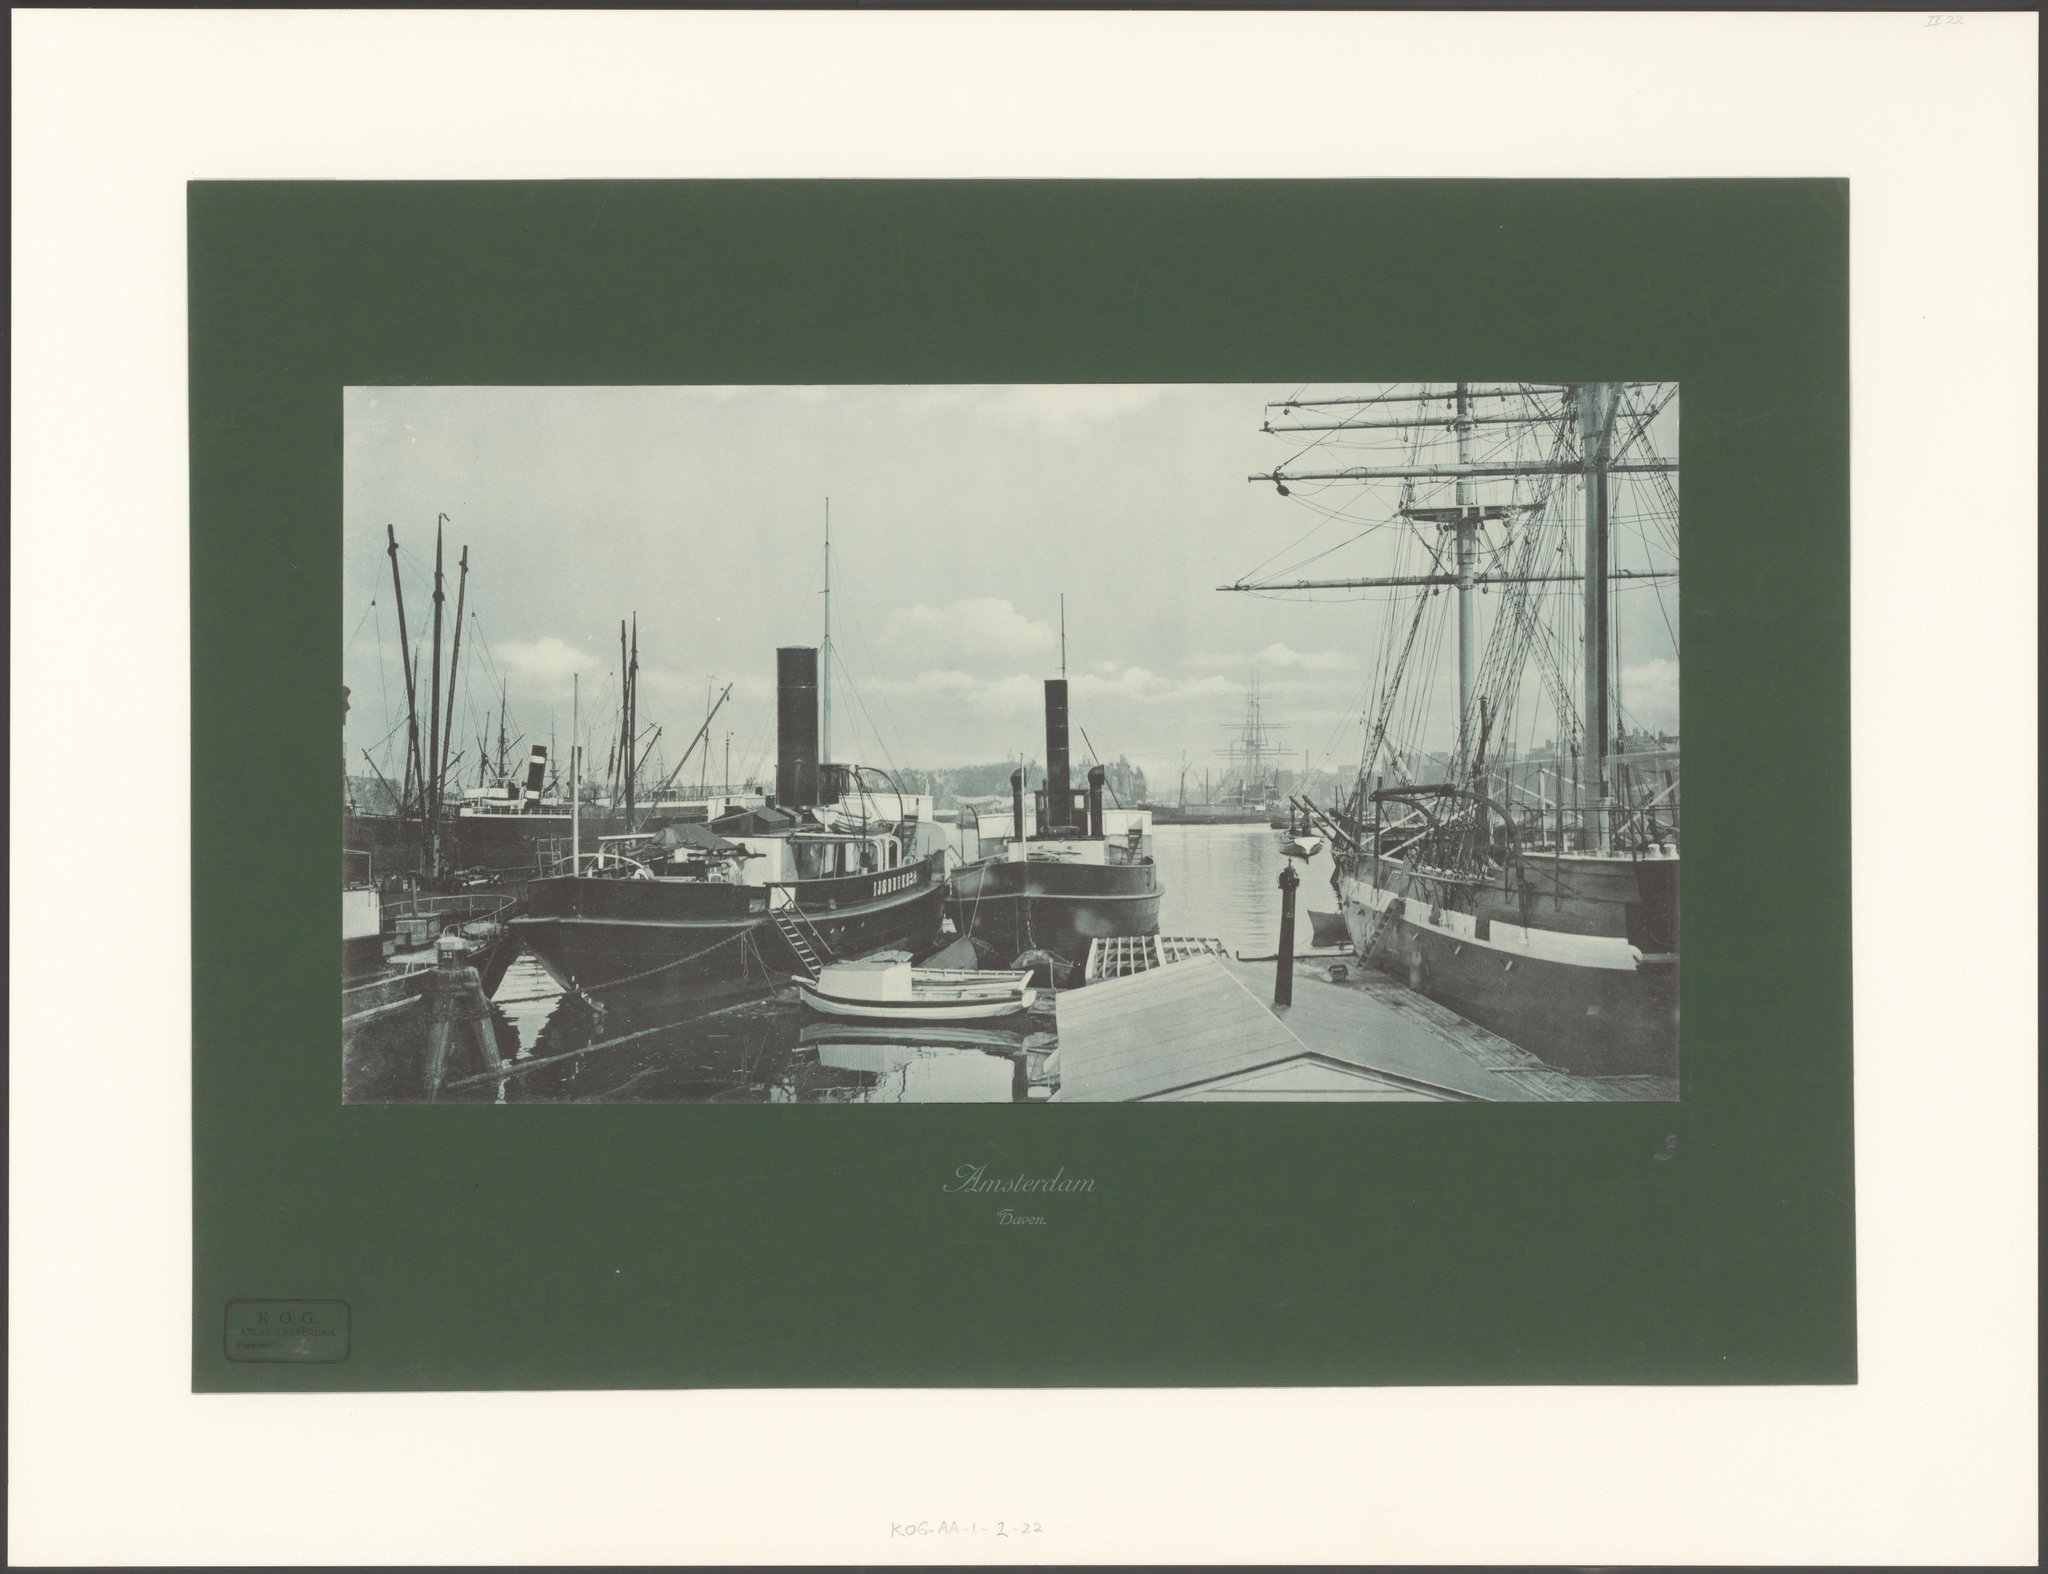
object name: photomechanical print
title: Gezicht op de haven van Amsterdam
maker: Anonymous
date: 1875-1950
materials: cardboard, paper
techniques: photograph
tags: city-view in general; 'veduta', river, ships (in general) - cc - more than one ship, port of amsterdam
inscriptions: inscription: ‘Amsterdam / haven.’, collector's mark: ‘2’ Lugt 1641b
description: Onderwerpsrubriek binnen de Atlas Amsterdam: Gezichten van het IJ op het Oostelijk gedeelte der stad, Nieuwebrug tot Zeeburg.